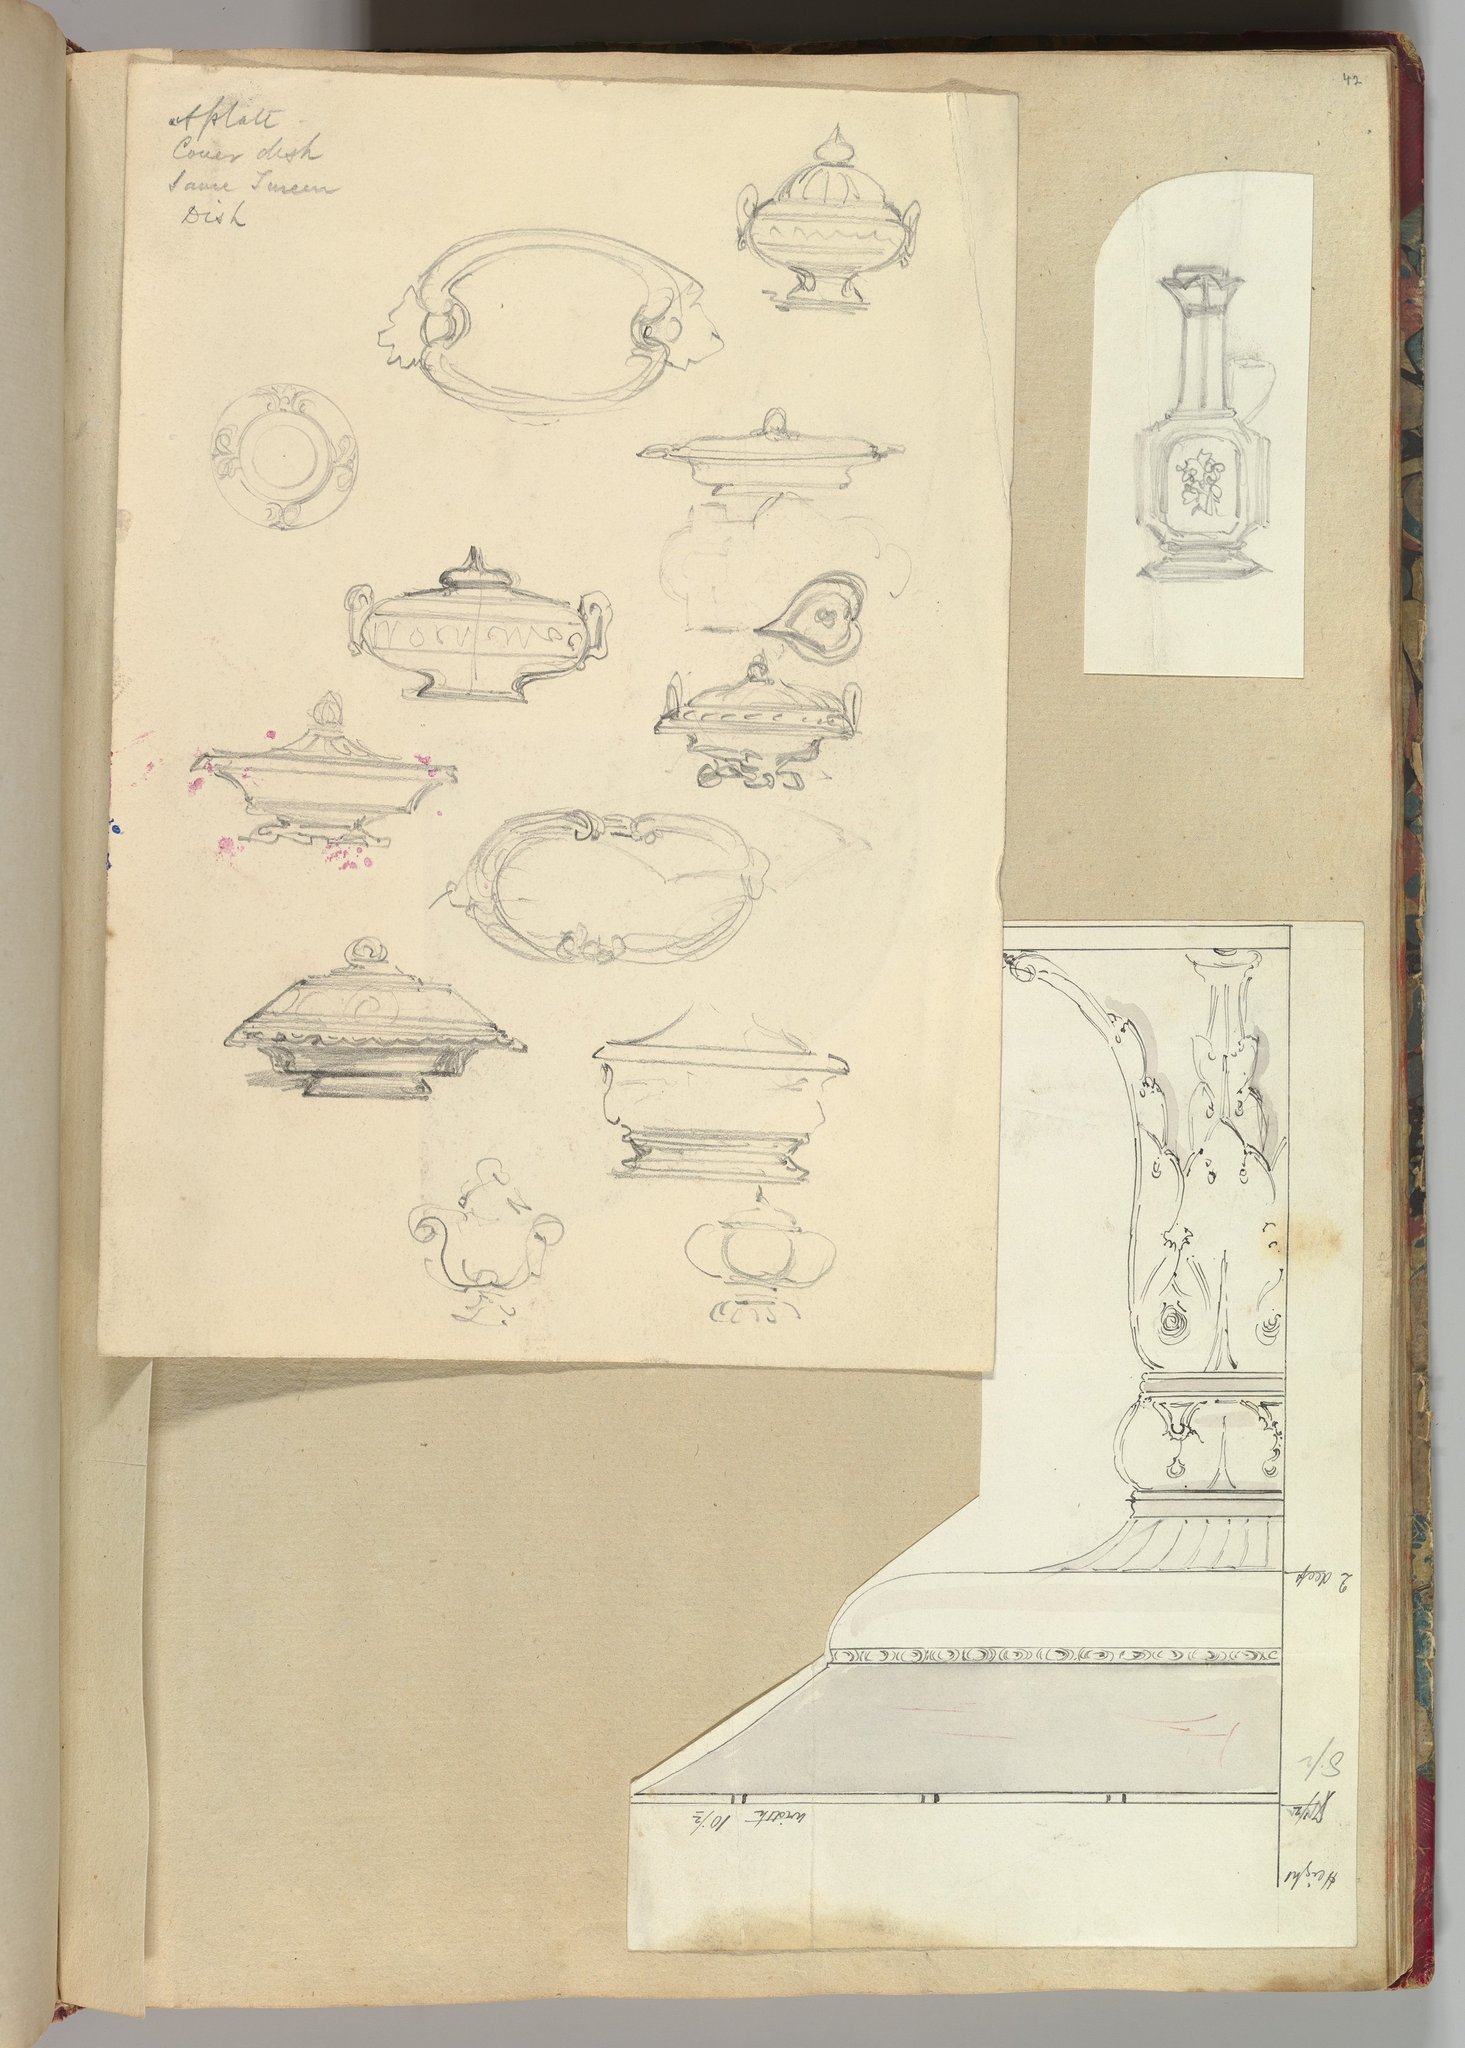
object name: drawing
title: Designs for Tureens and a Platter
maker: alfred henry forrester [alfred crowquill]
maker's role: artist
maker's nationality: british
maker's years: 1804-1872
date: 1845-1855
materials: graphite, ink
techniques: brush, pen, wash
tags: dishes